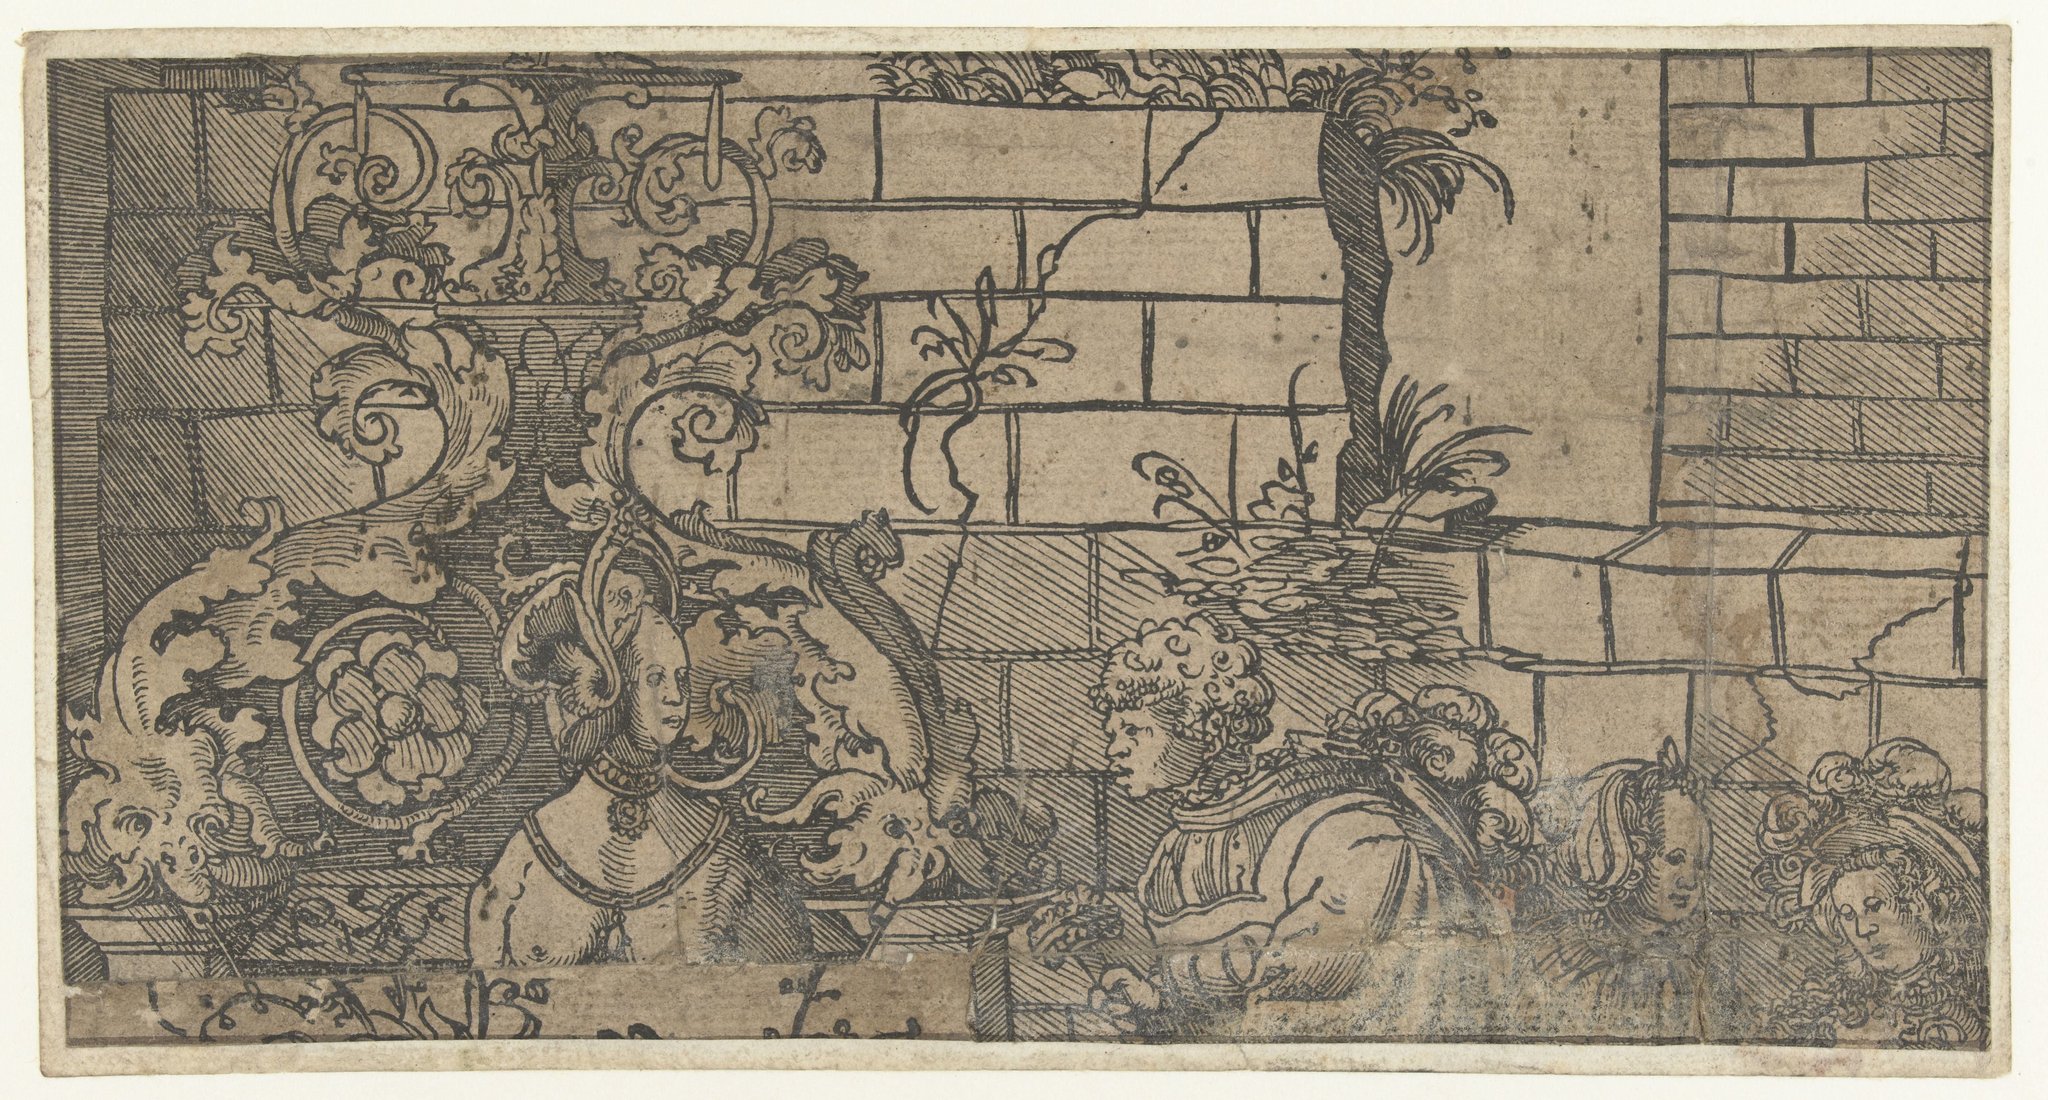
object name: print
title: Bathseba en een dienaar van David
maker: Anonymous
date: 1520-1540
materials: paper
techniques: woodcut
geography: antwerp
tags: bathsheba receives a letter from david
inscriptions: collector's mark: Lugt 240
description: Fragment van een prent van Bathseba en dienaar van David en twee dames, stenen muur als achtergrond. Fragment geplakt op papier, hoek linkersonder komt van andere prent.